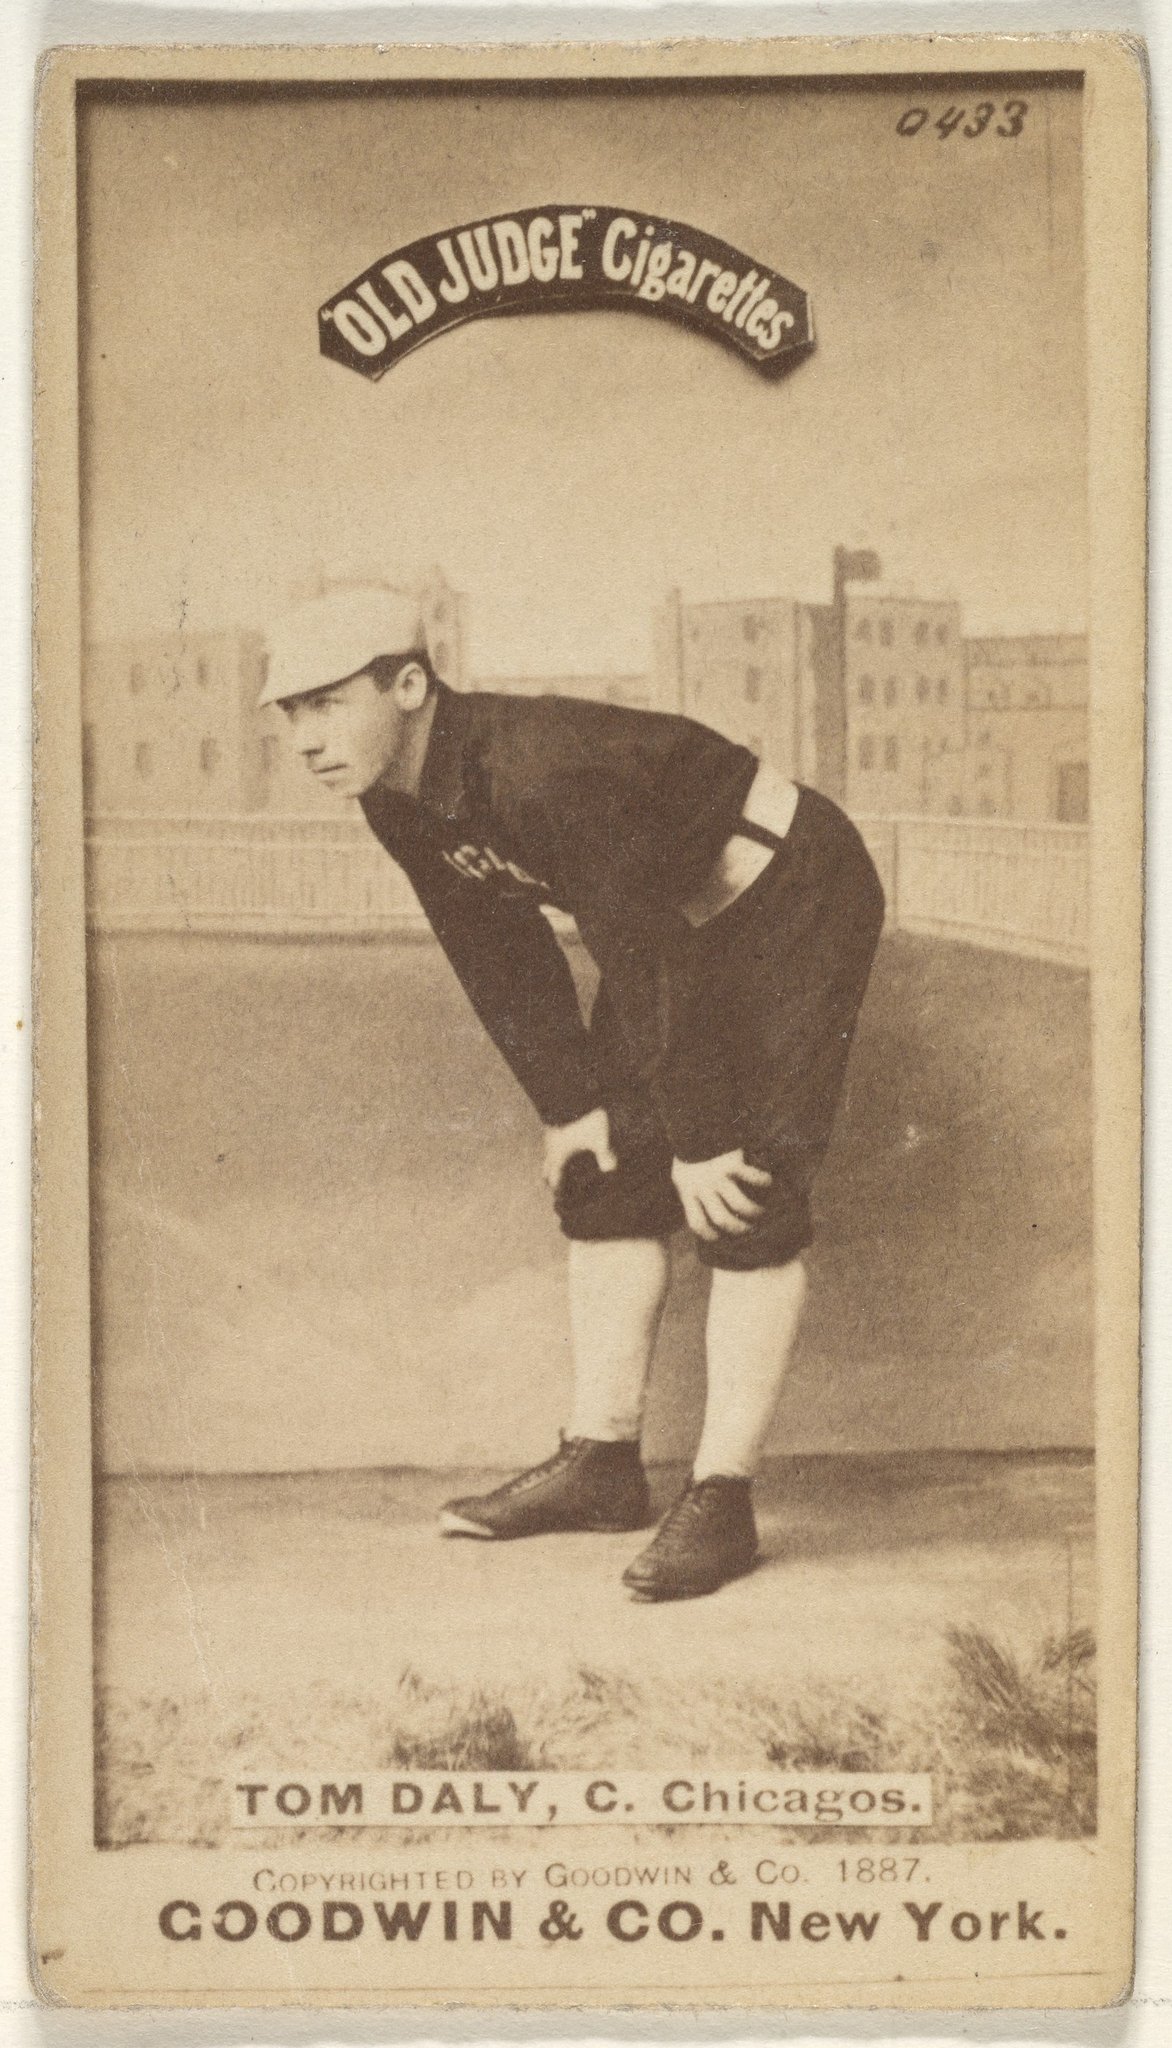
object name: baseball card, photograph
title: Tom Daly, Catcher, Chicago, from the Old Judge series (N172) for Old Judge Cigarettes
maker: goodwin & company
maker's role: publisher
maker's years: 1850-1950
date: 1887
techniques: albumen silver print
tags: men,portraits,baseball,athletes